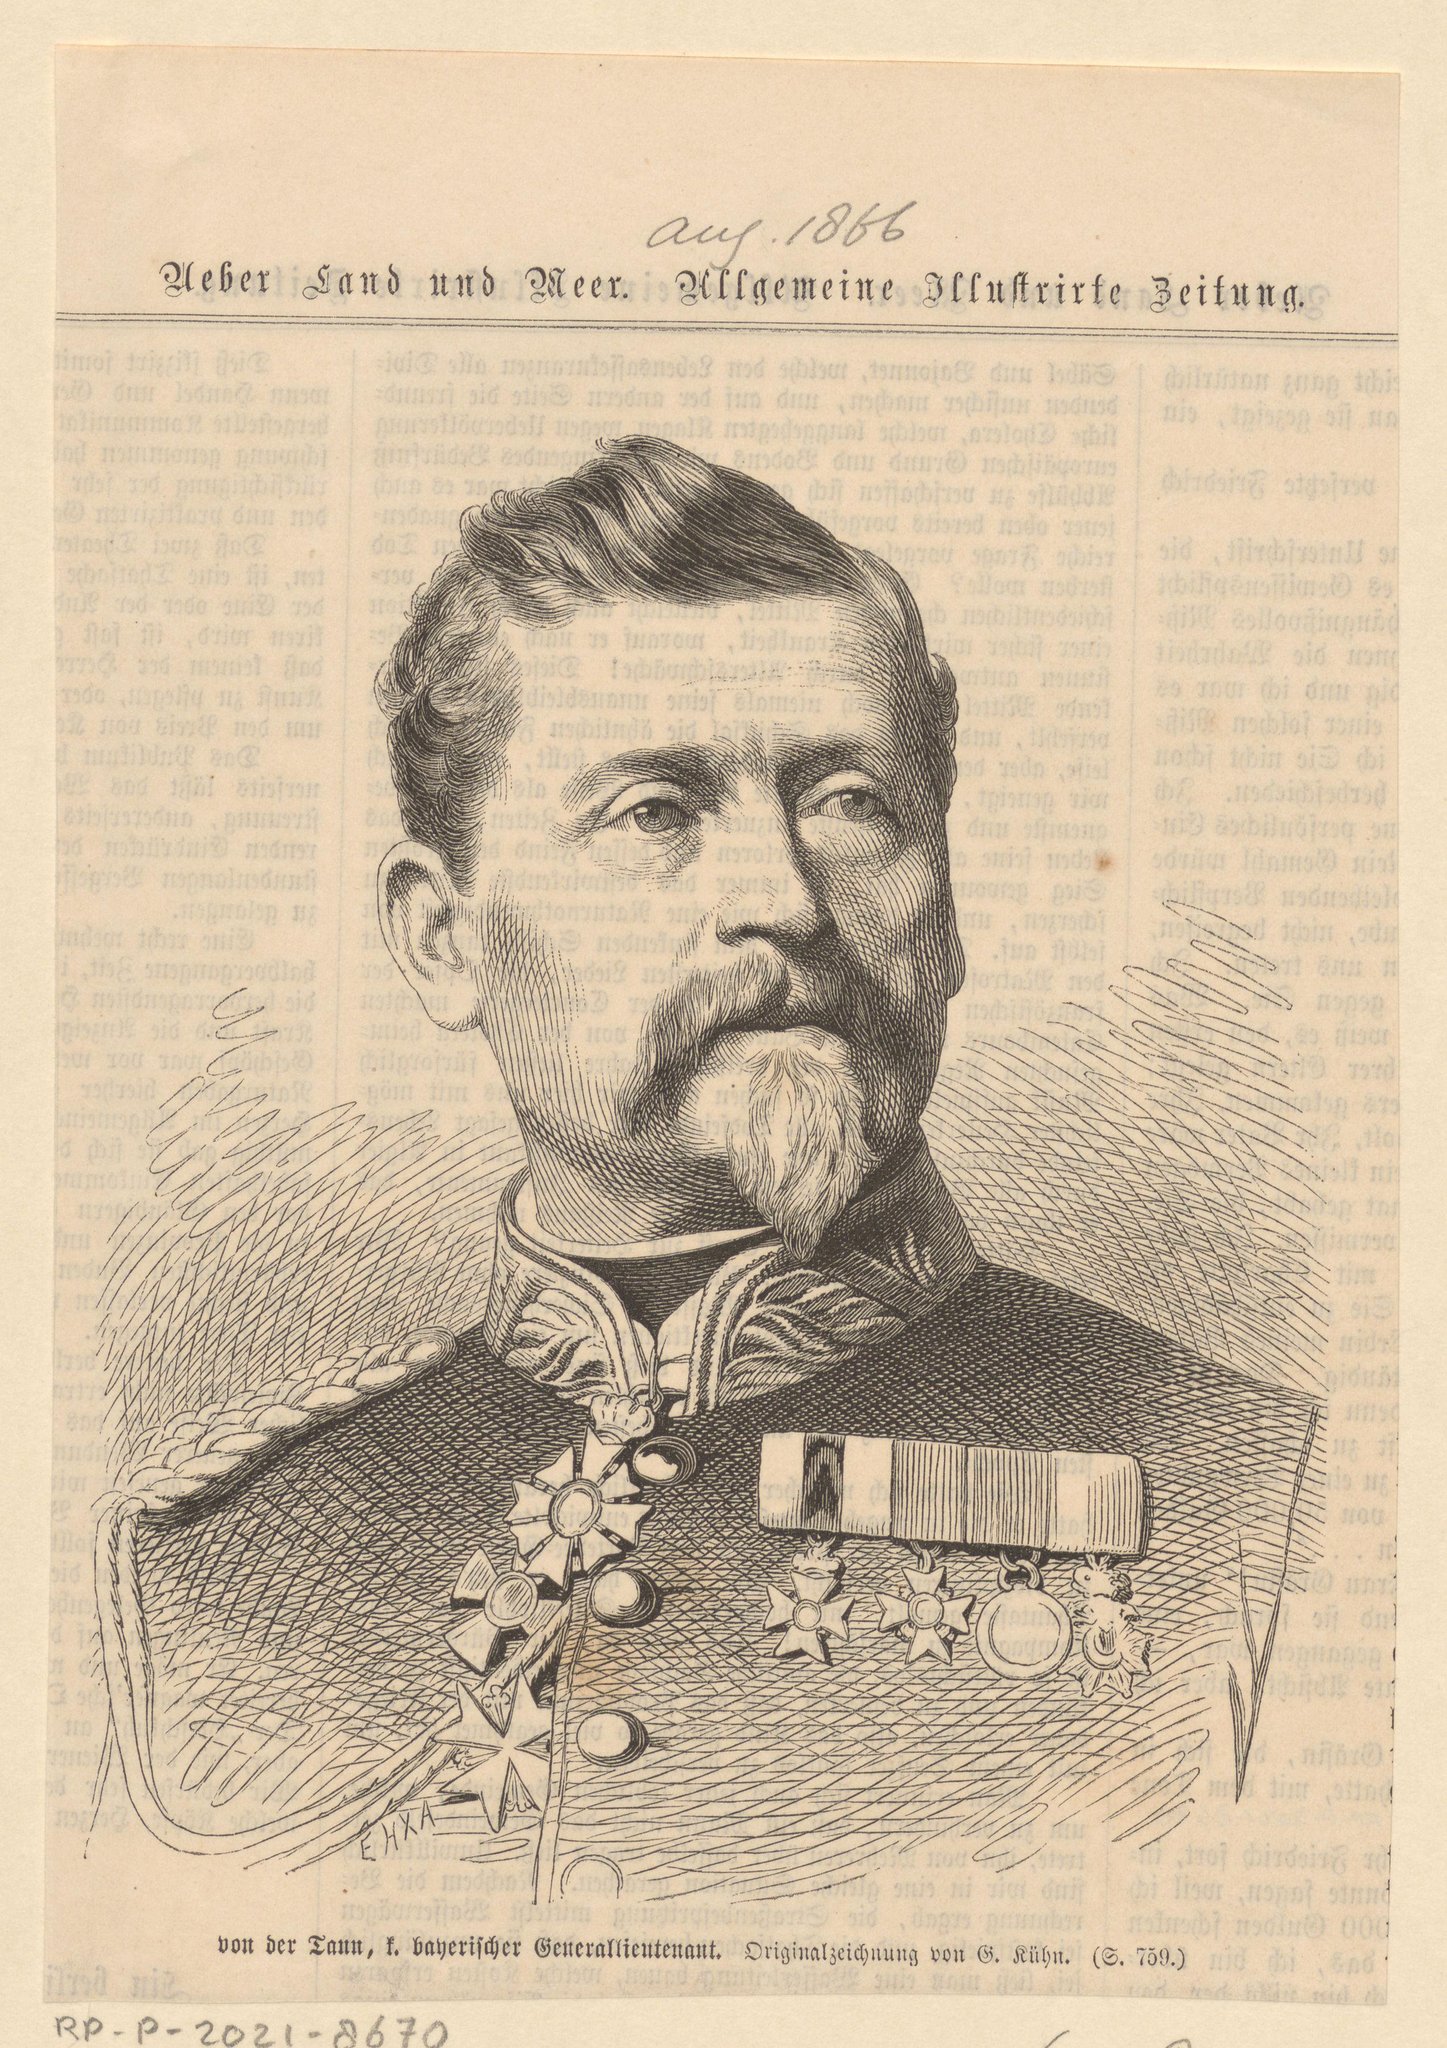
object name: print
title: Portret van Ludwig von der Tann-Rathsamhausen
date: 1866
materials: paper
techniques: letterpress printing, engraving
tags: commander-in-chief, general, marshal, historical persons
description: Prent uit: Über Land und Meer 8 (1866), nr. 48, augustus 1866, p. 757.